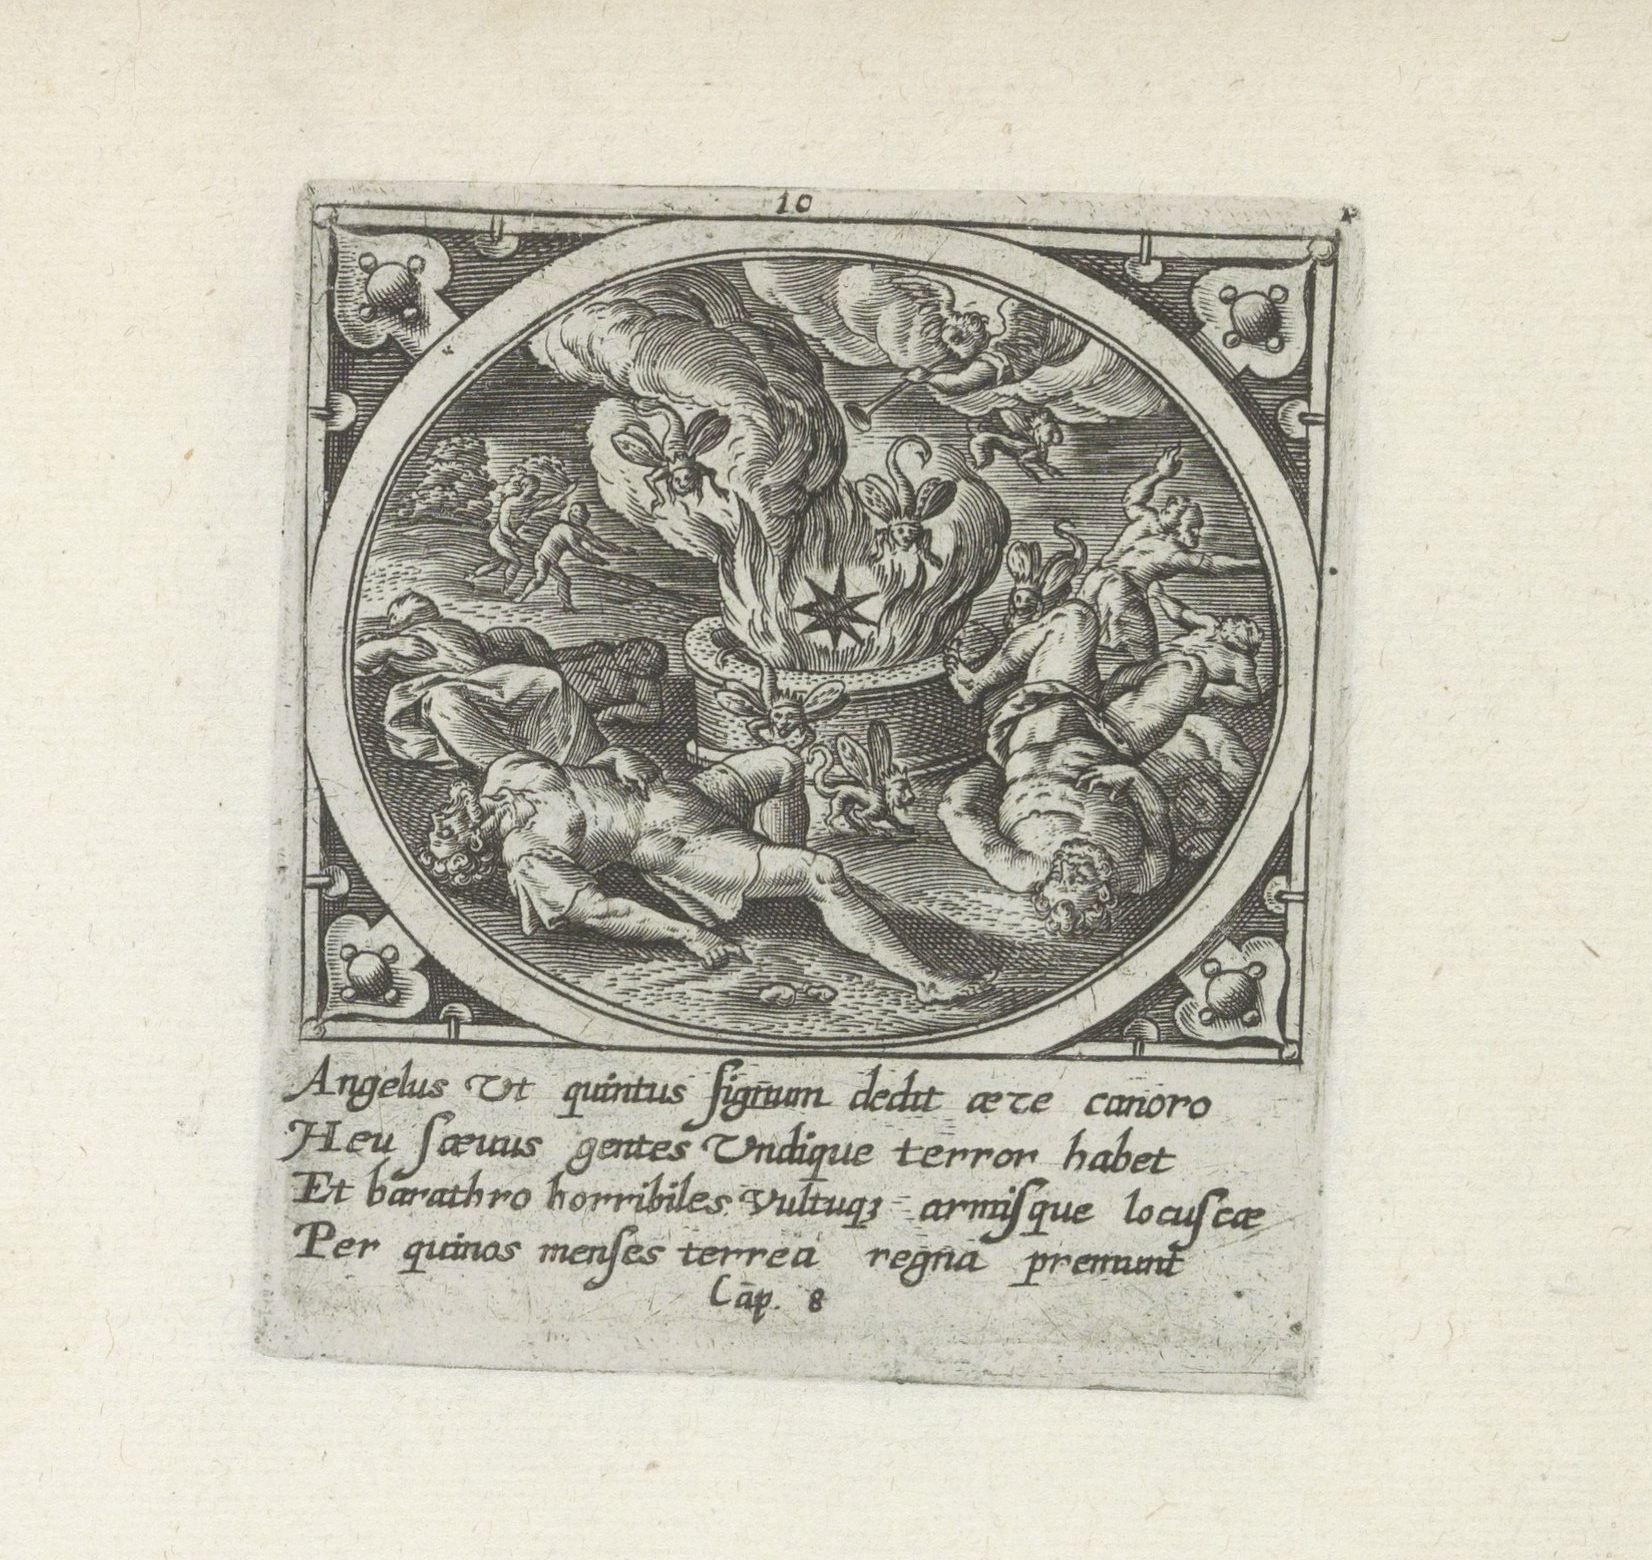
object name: album leaf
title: Openbaring van Johannes op Patmos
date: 1585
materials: paper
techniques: engraving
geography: antwerp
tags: the fifth of the seven angels sounds the trumpet: the falling star opens up the bottomless pit: smoke comes out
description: De vijfde engel blaast op de bazuin en een vallende ster opent de bodemloze put, waaruit rook en sprinkhanen te voorschijn komen die de mensen zonder stempel op hun voorhoofd pijnigen. Onder de voorstelling een verwijzing in het Latijn naar de Bijbeltekst in Op. 8. Deze prent maakt deel uit van een album.